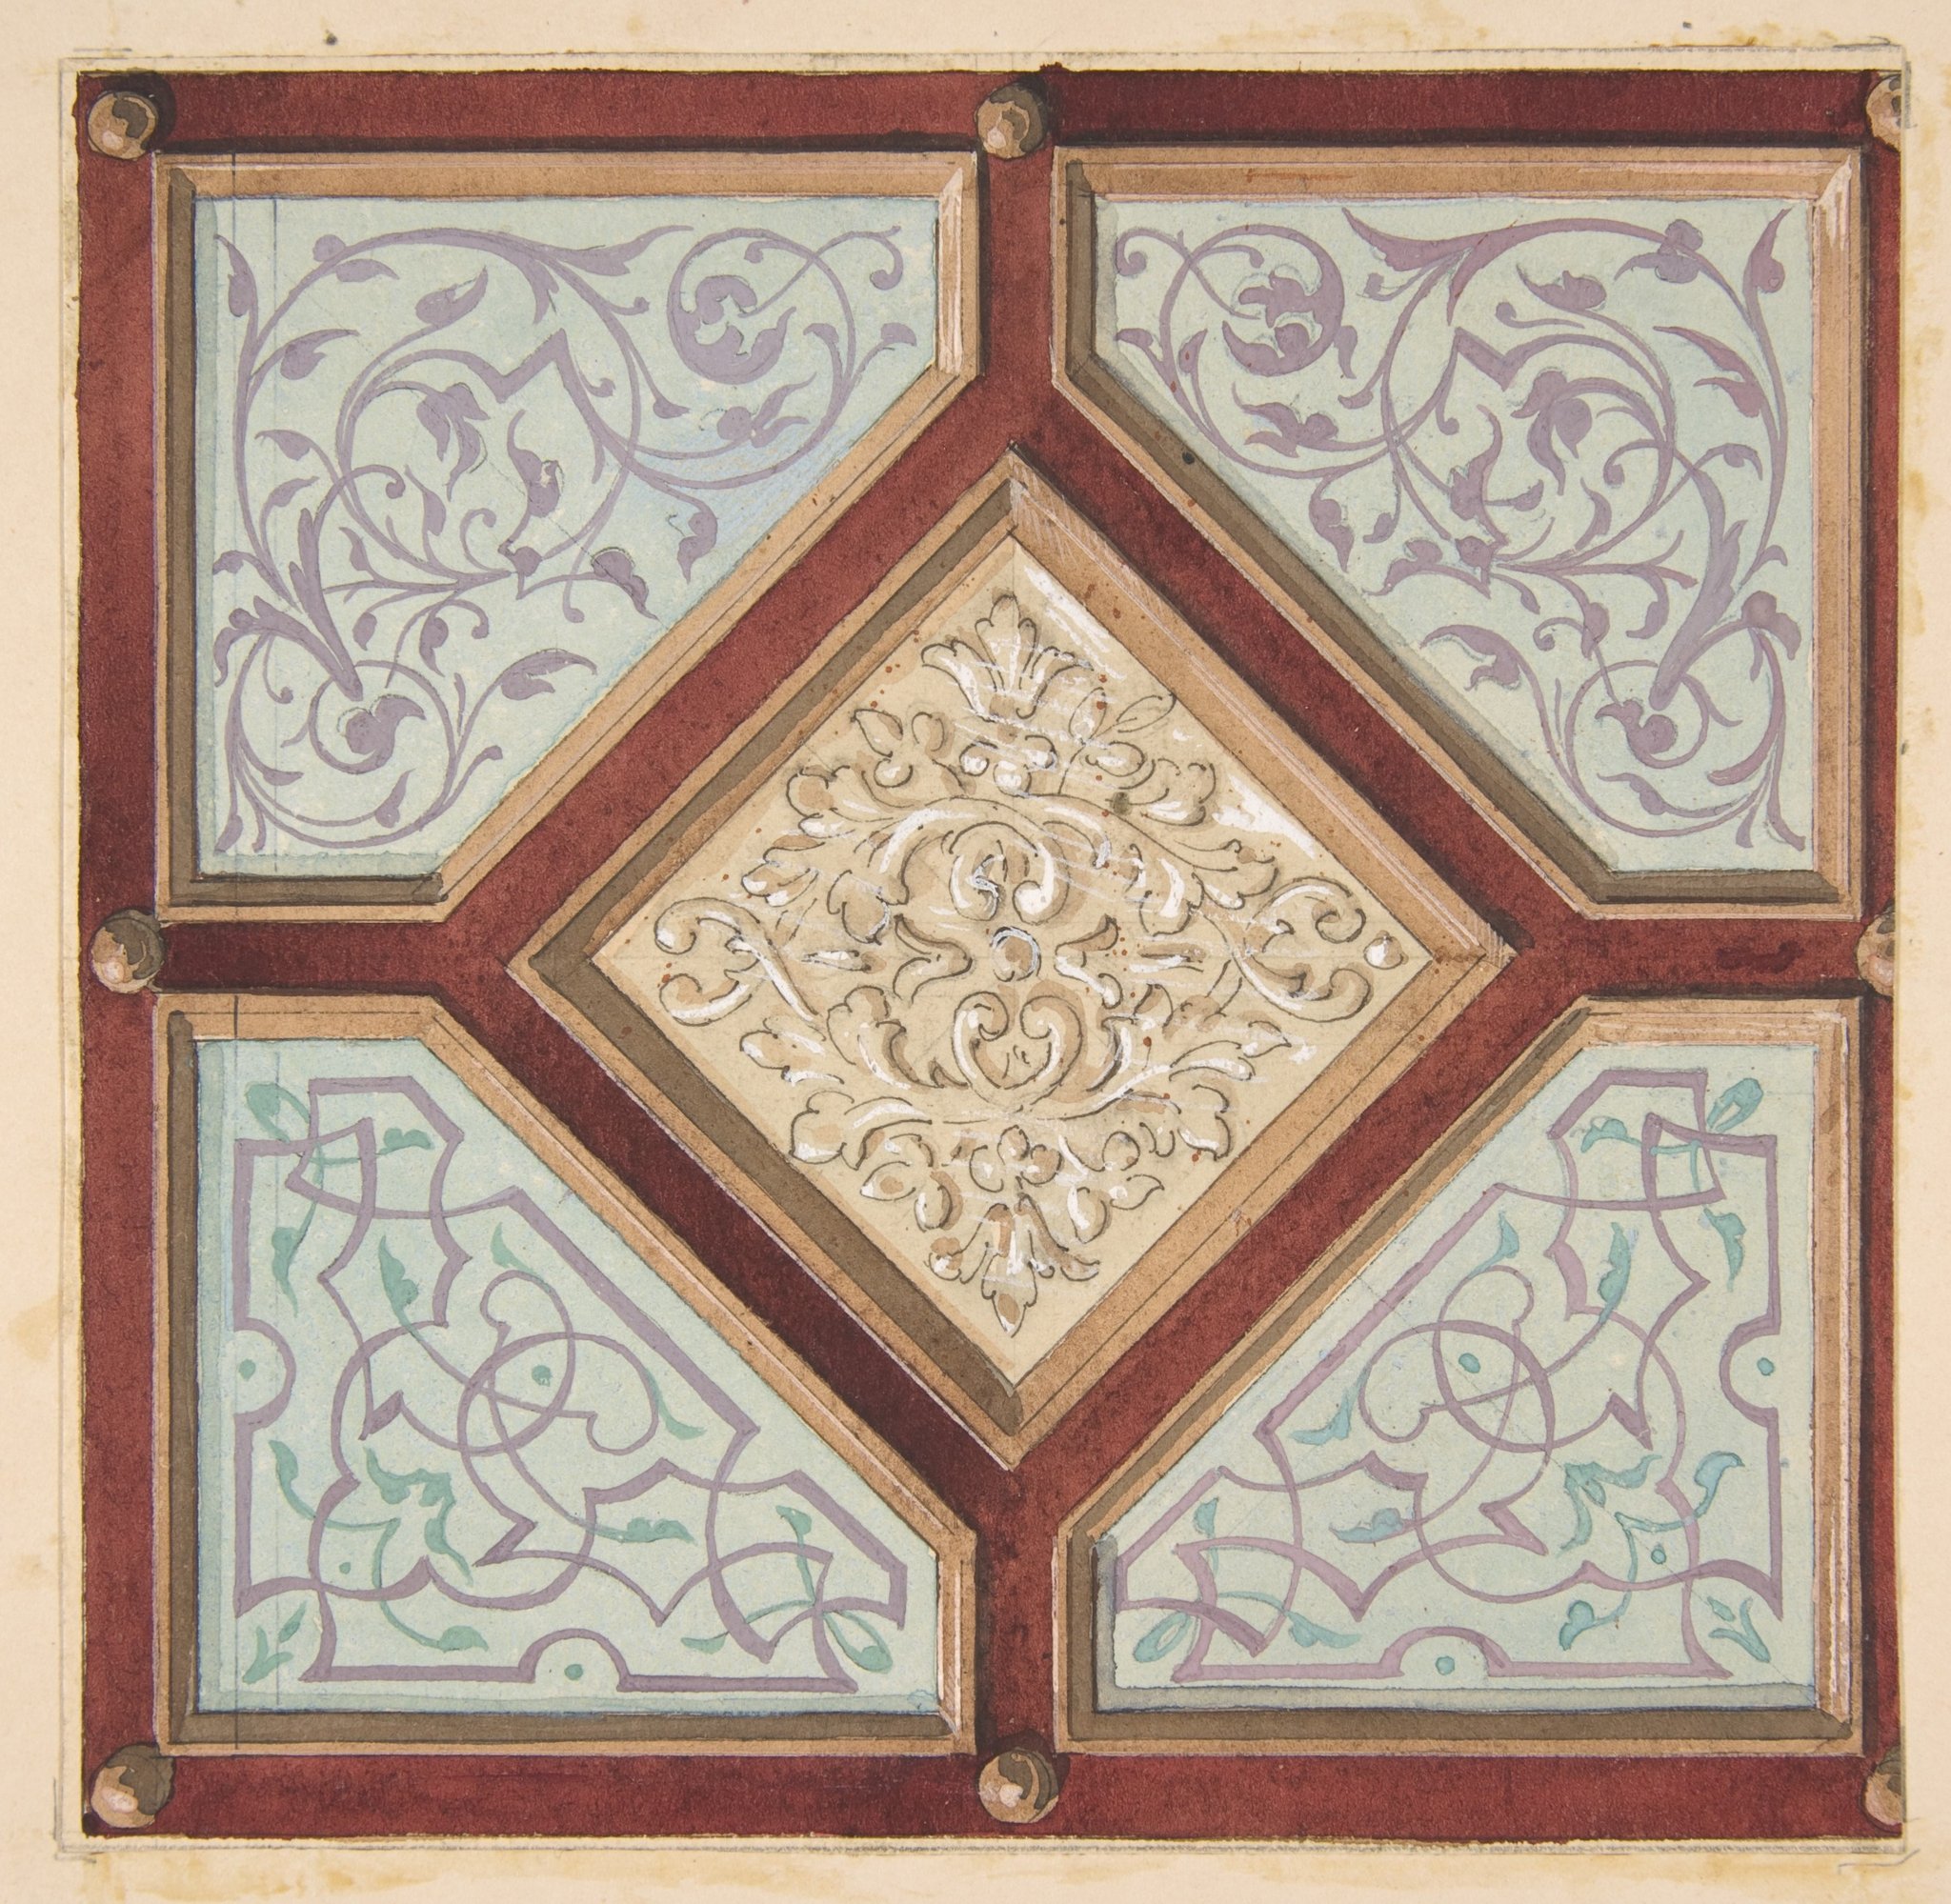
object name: drawing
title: Design for a coffered ceiling with alternative decorative patterns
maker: jules-edmond-charles lachaise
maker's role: artist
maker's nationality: french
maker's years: 1897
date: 1840-1897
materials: gouache, ink, watercolor, paper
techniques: inlay, pen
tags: ceilings